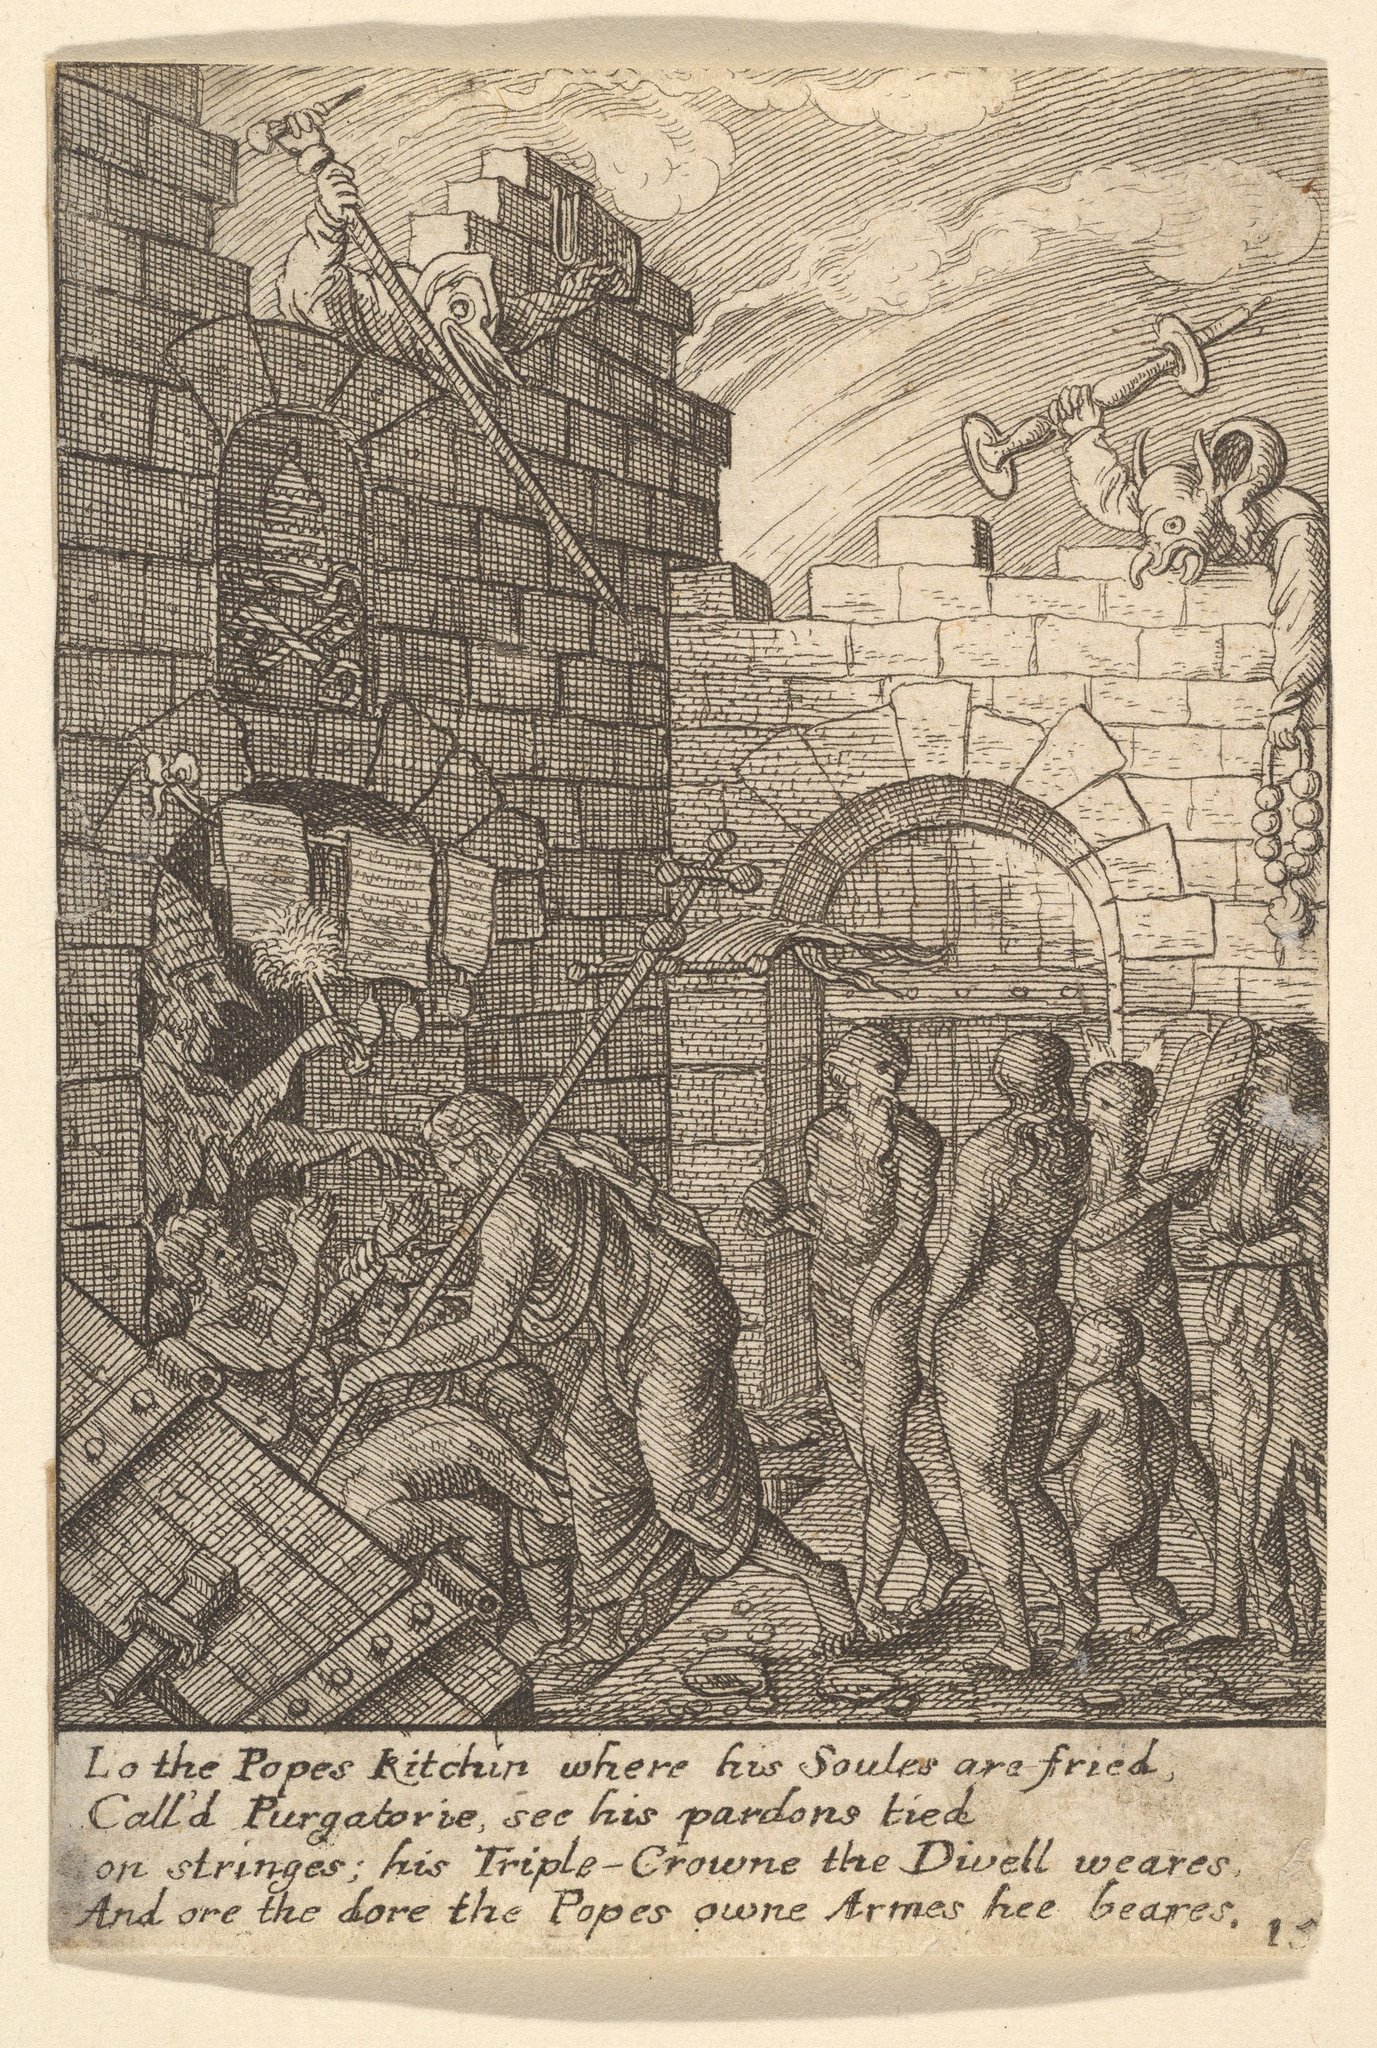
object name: print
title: Descent into Hell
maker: wenceslaus hollar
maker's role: artist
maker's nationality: bohemian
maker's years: 1607-1677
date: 1644-1652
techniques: etching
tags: christ,devil,hell,moses,adam,eve